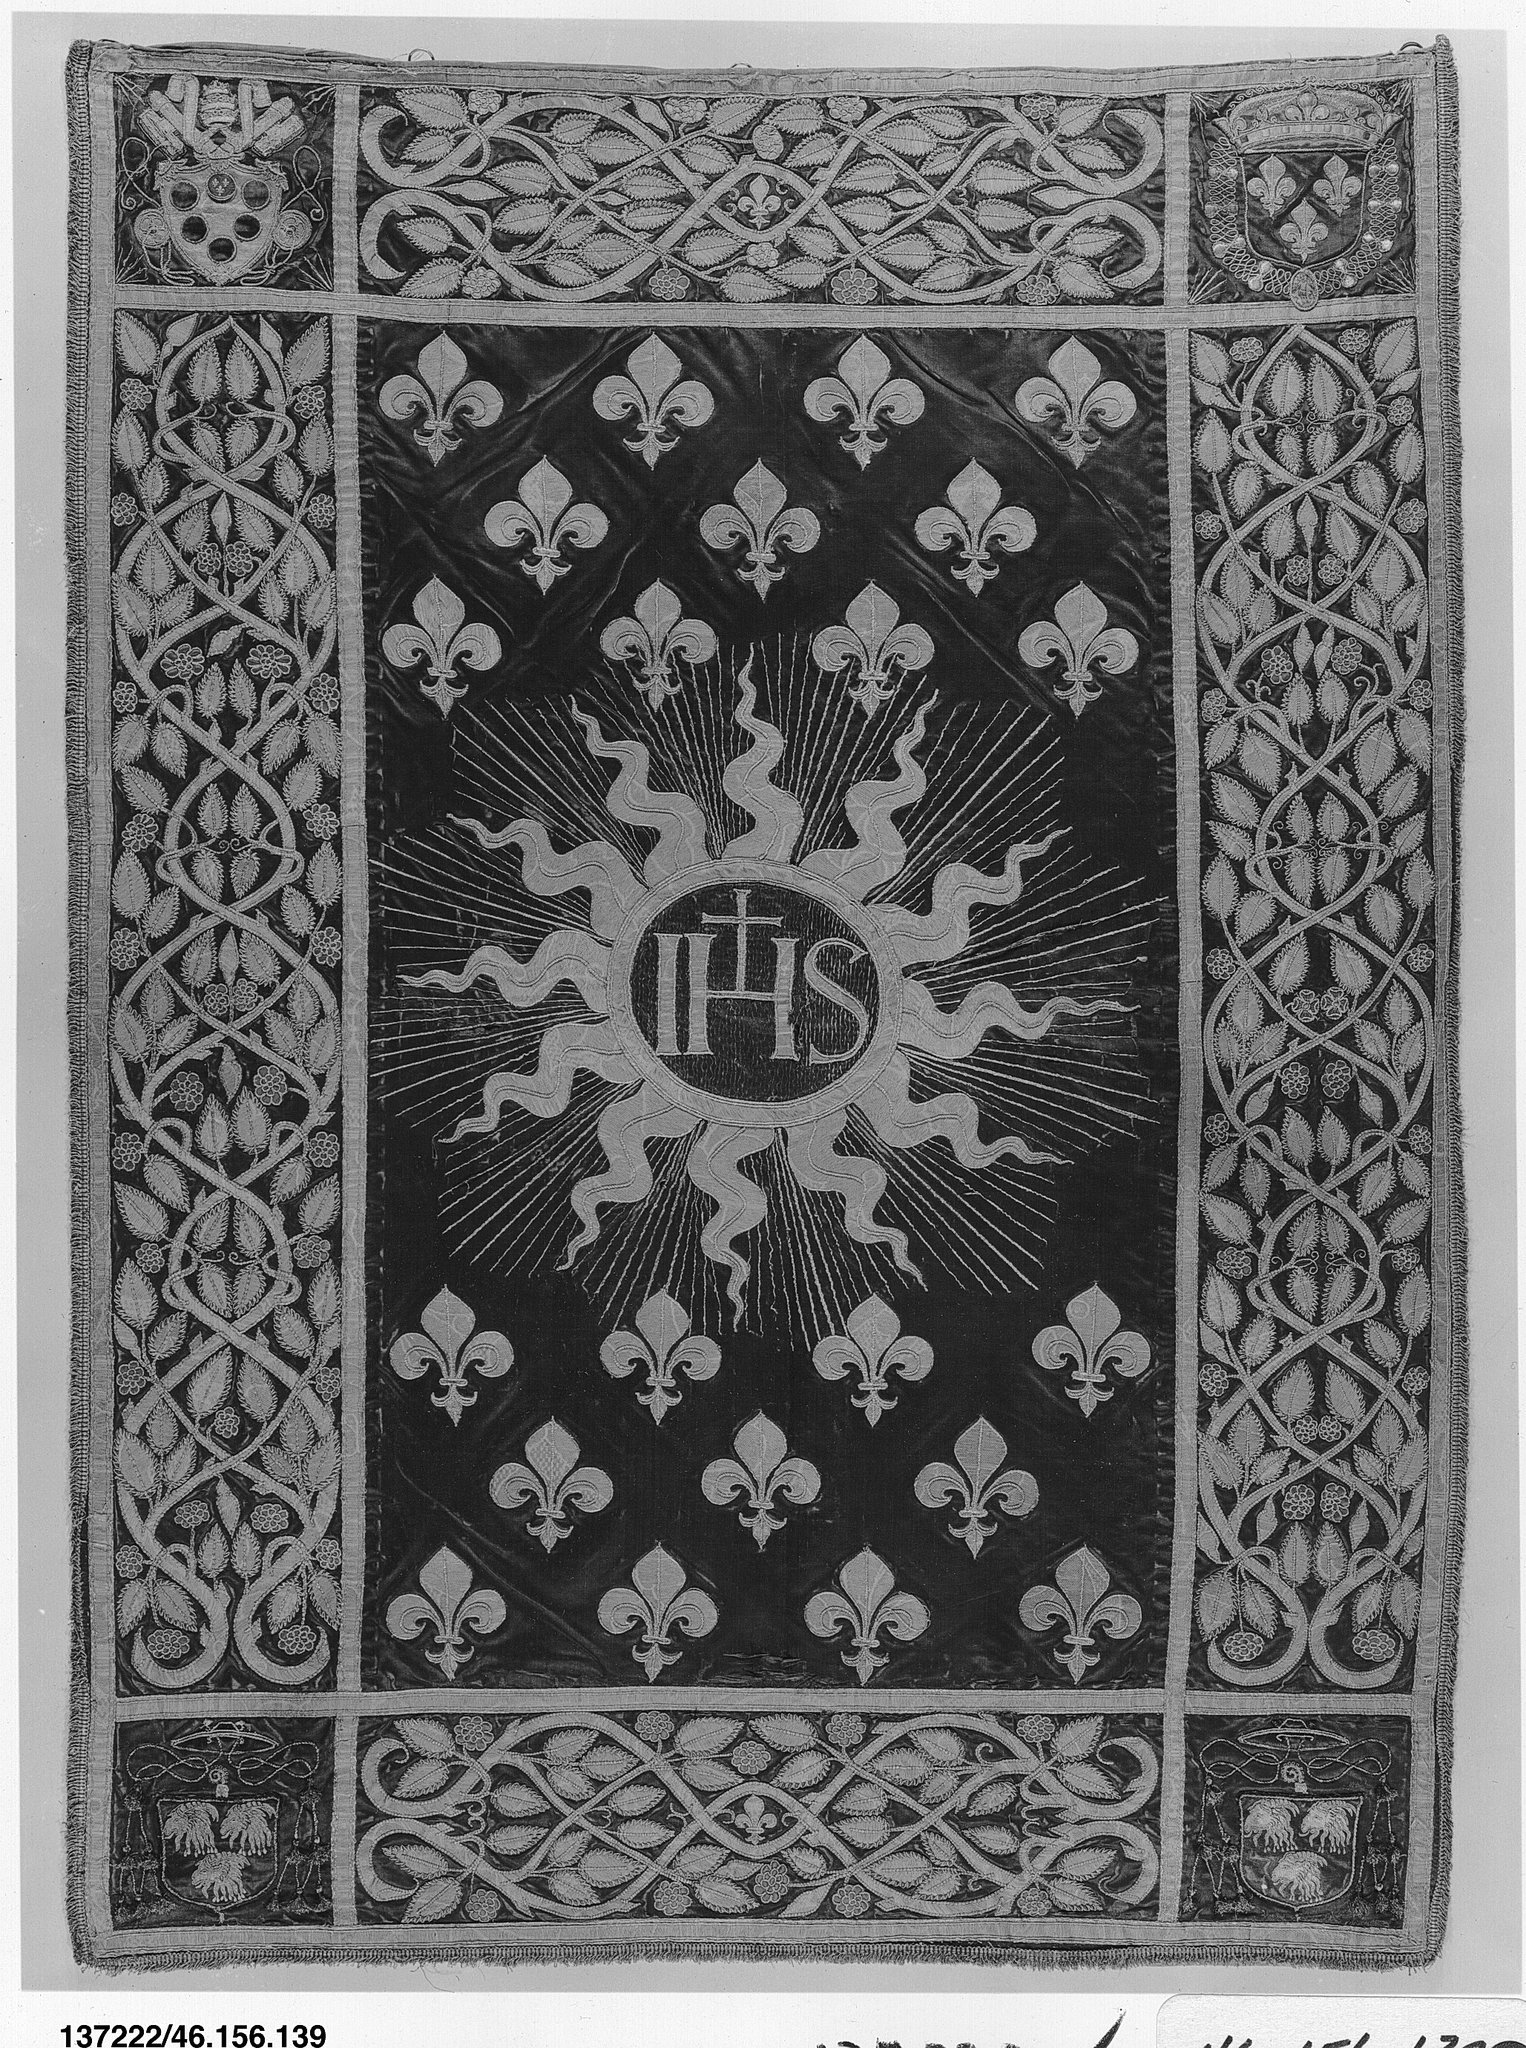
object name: processional banner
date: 1516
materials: metal thread, silk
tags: coat of arms